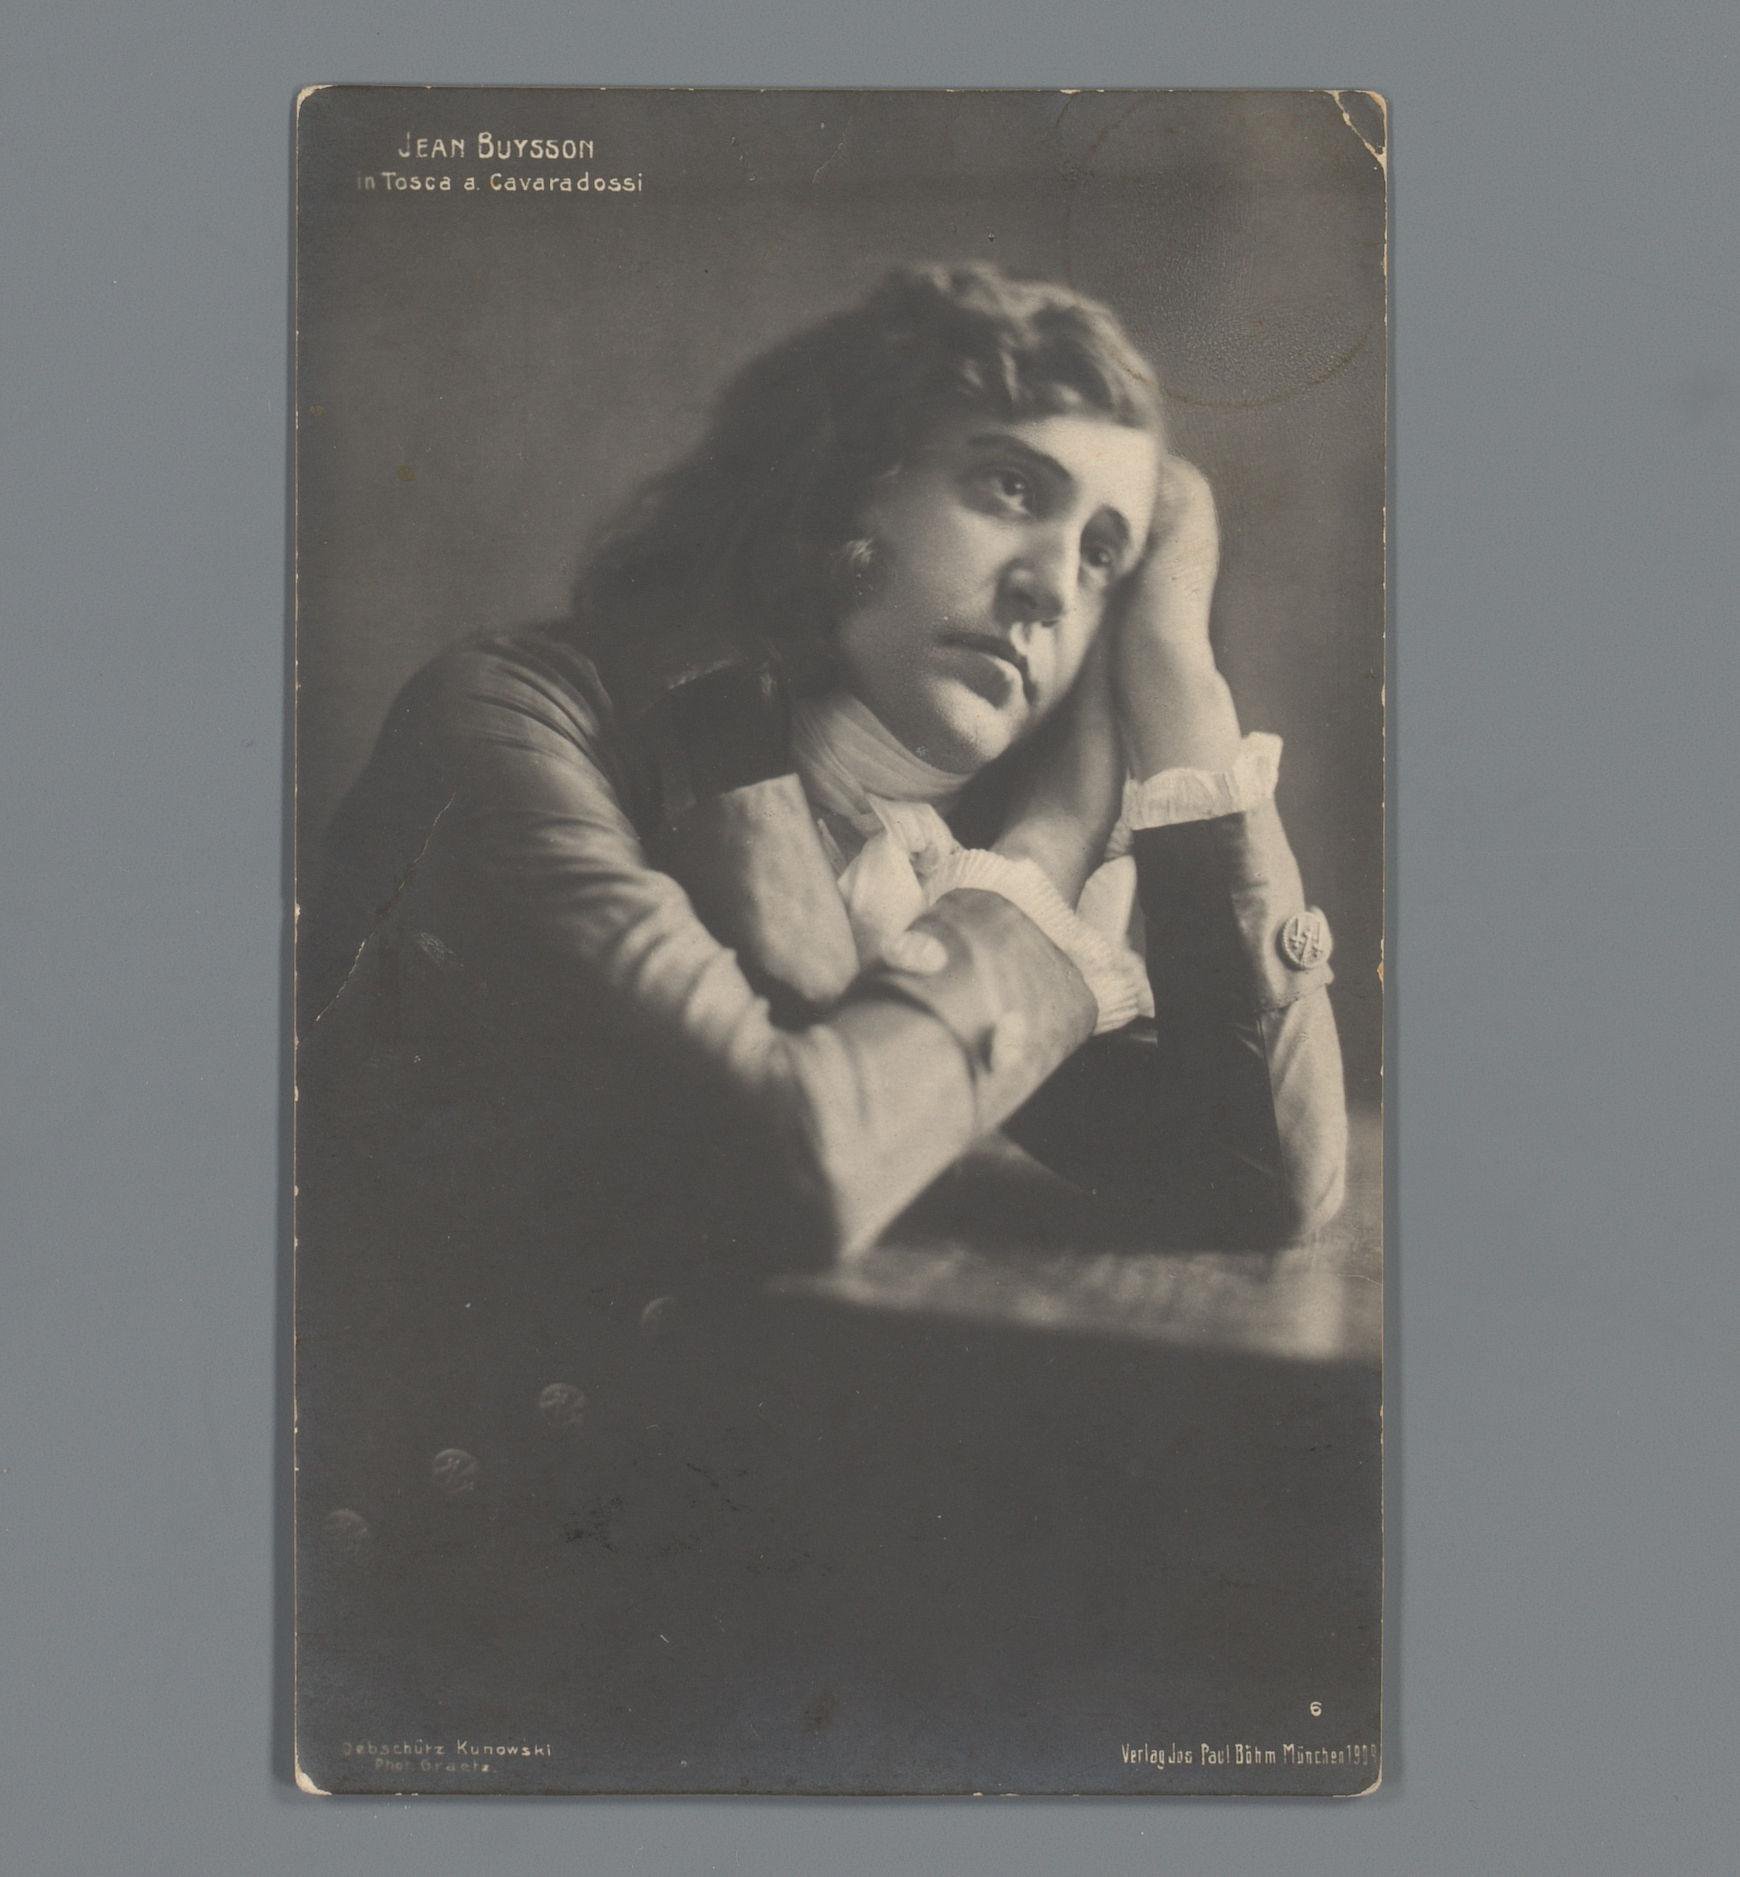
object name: photograph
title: Jean Buysson in Tosca a. Cavaradossi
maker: josef paul böhm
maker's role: publisher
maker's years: 1881-1953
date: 1909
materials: paper, ink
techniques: gelatin silver print, pen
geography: munich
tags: amsterdam, paris, historical persons (portraits and scenes from the life)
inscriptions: number: ‘6’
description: Portret van Jean Buysson als Mario Cavaradossi in Tosca.